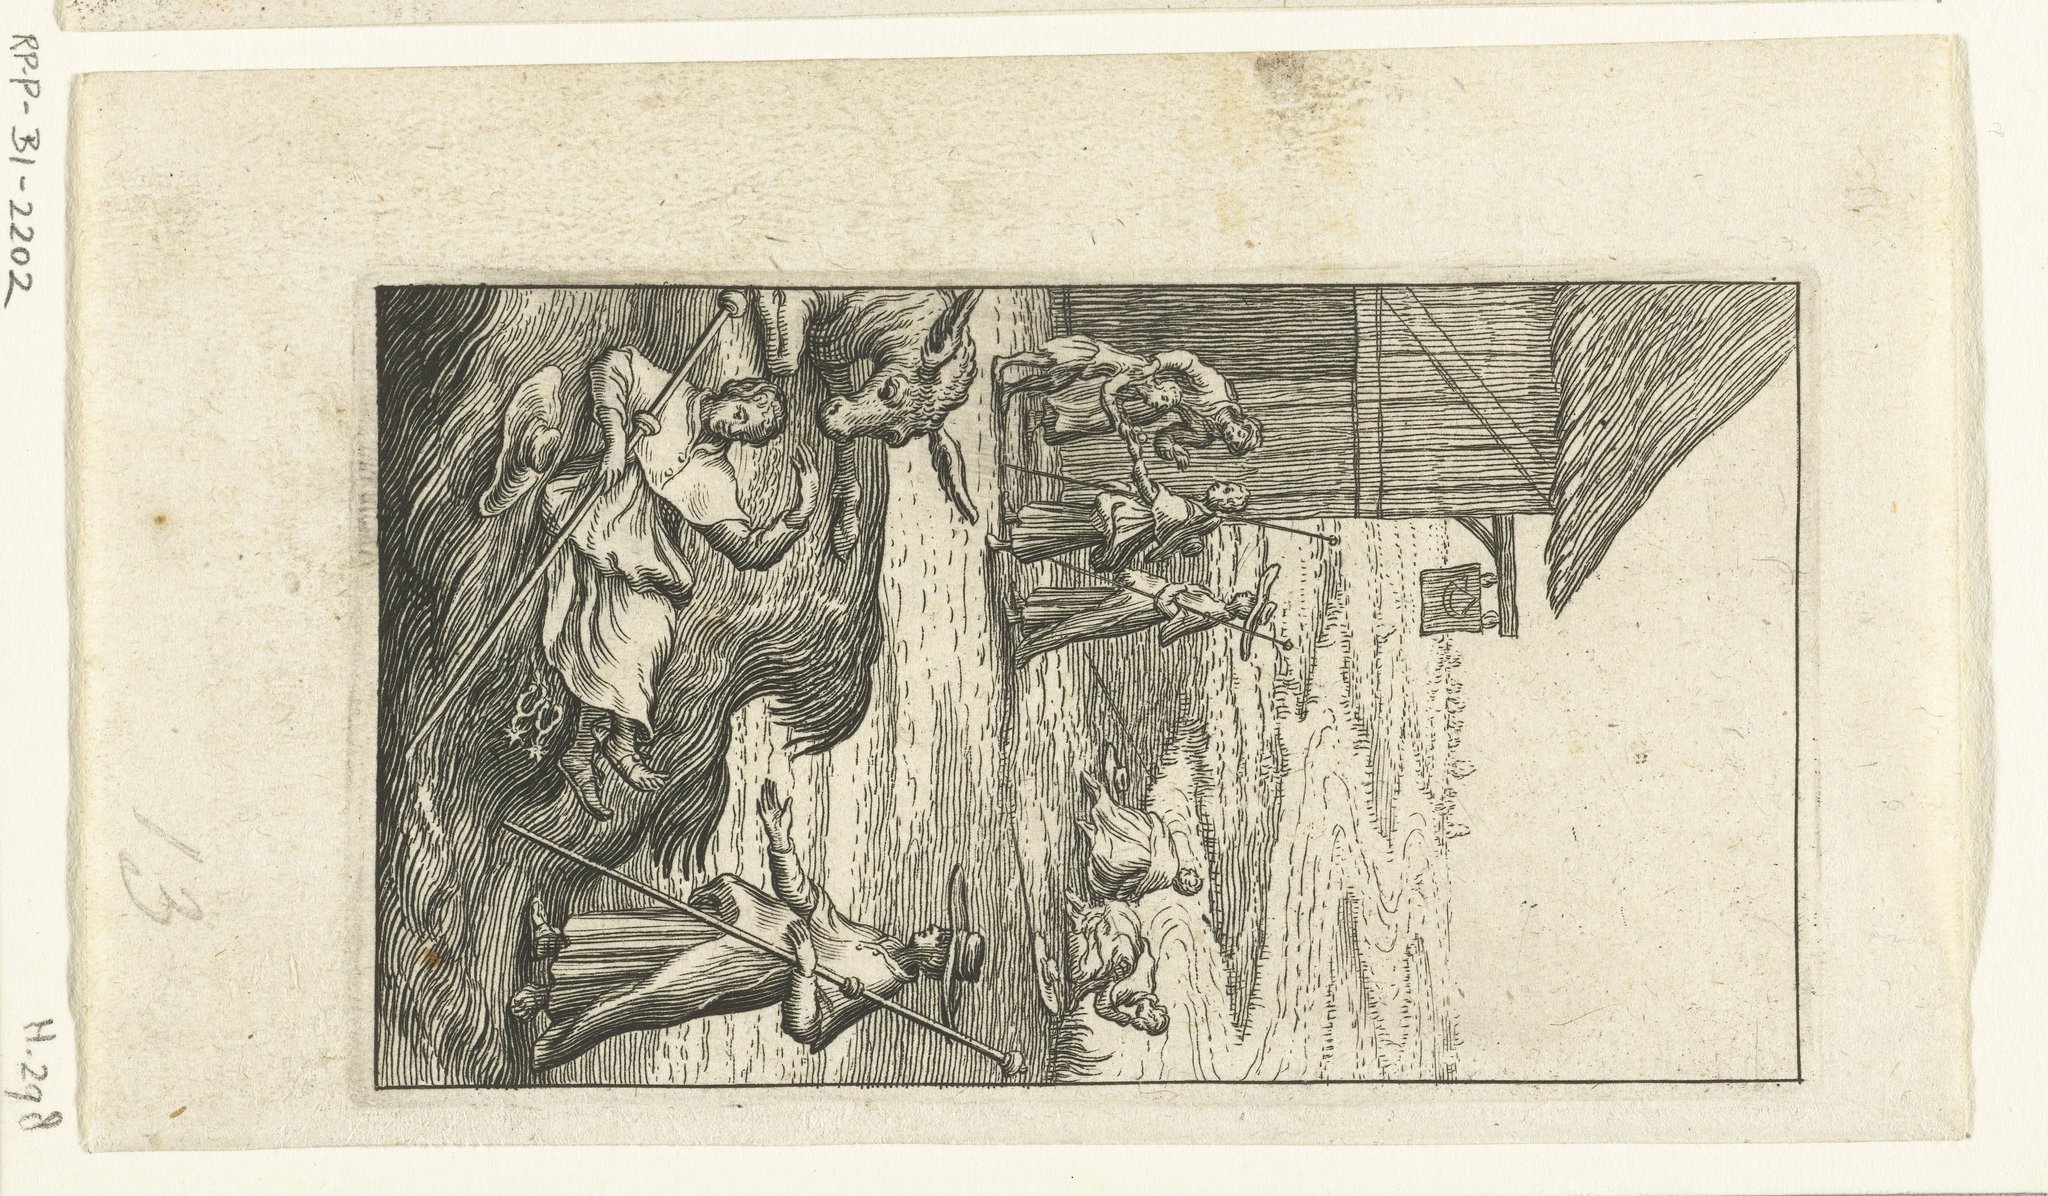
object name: book illustration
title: Duyfkens en Willemynkens pelgrimagie tot haren beminden binnen Iervsalem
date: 1590-1627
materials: paper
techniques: engraving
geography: antwerp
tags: ass, donkey, spur, pilgrimage, pilgrim(s) under way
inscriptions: collector's mark: Lugt 2228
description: Prent uit: Boëtius Adamsz. Bolswert, Duyfkens en Willemynkens pelgrimagie tot haren beminden binnen Iervsalem. Haerlieder teghenspoet, belet en eynde, Antwerpen, Hendrick Aertssens, eerste druk 1627. Op het verso van deze prent staat geen tekst, waarschijnlijk is het blad afkomstig uit een latere druk.